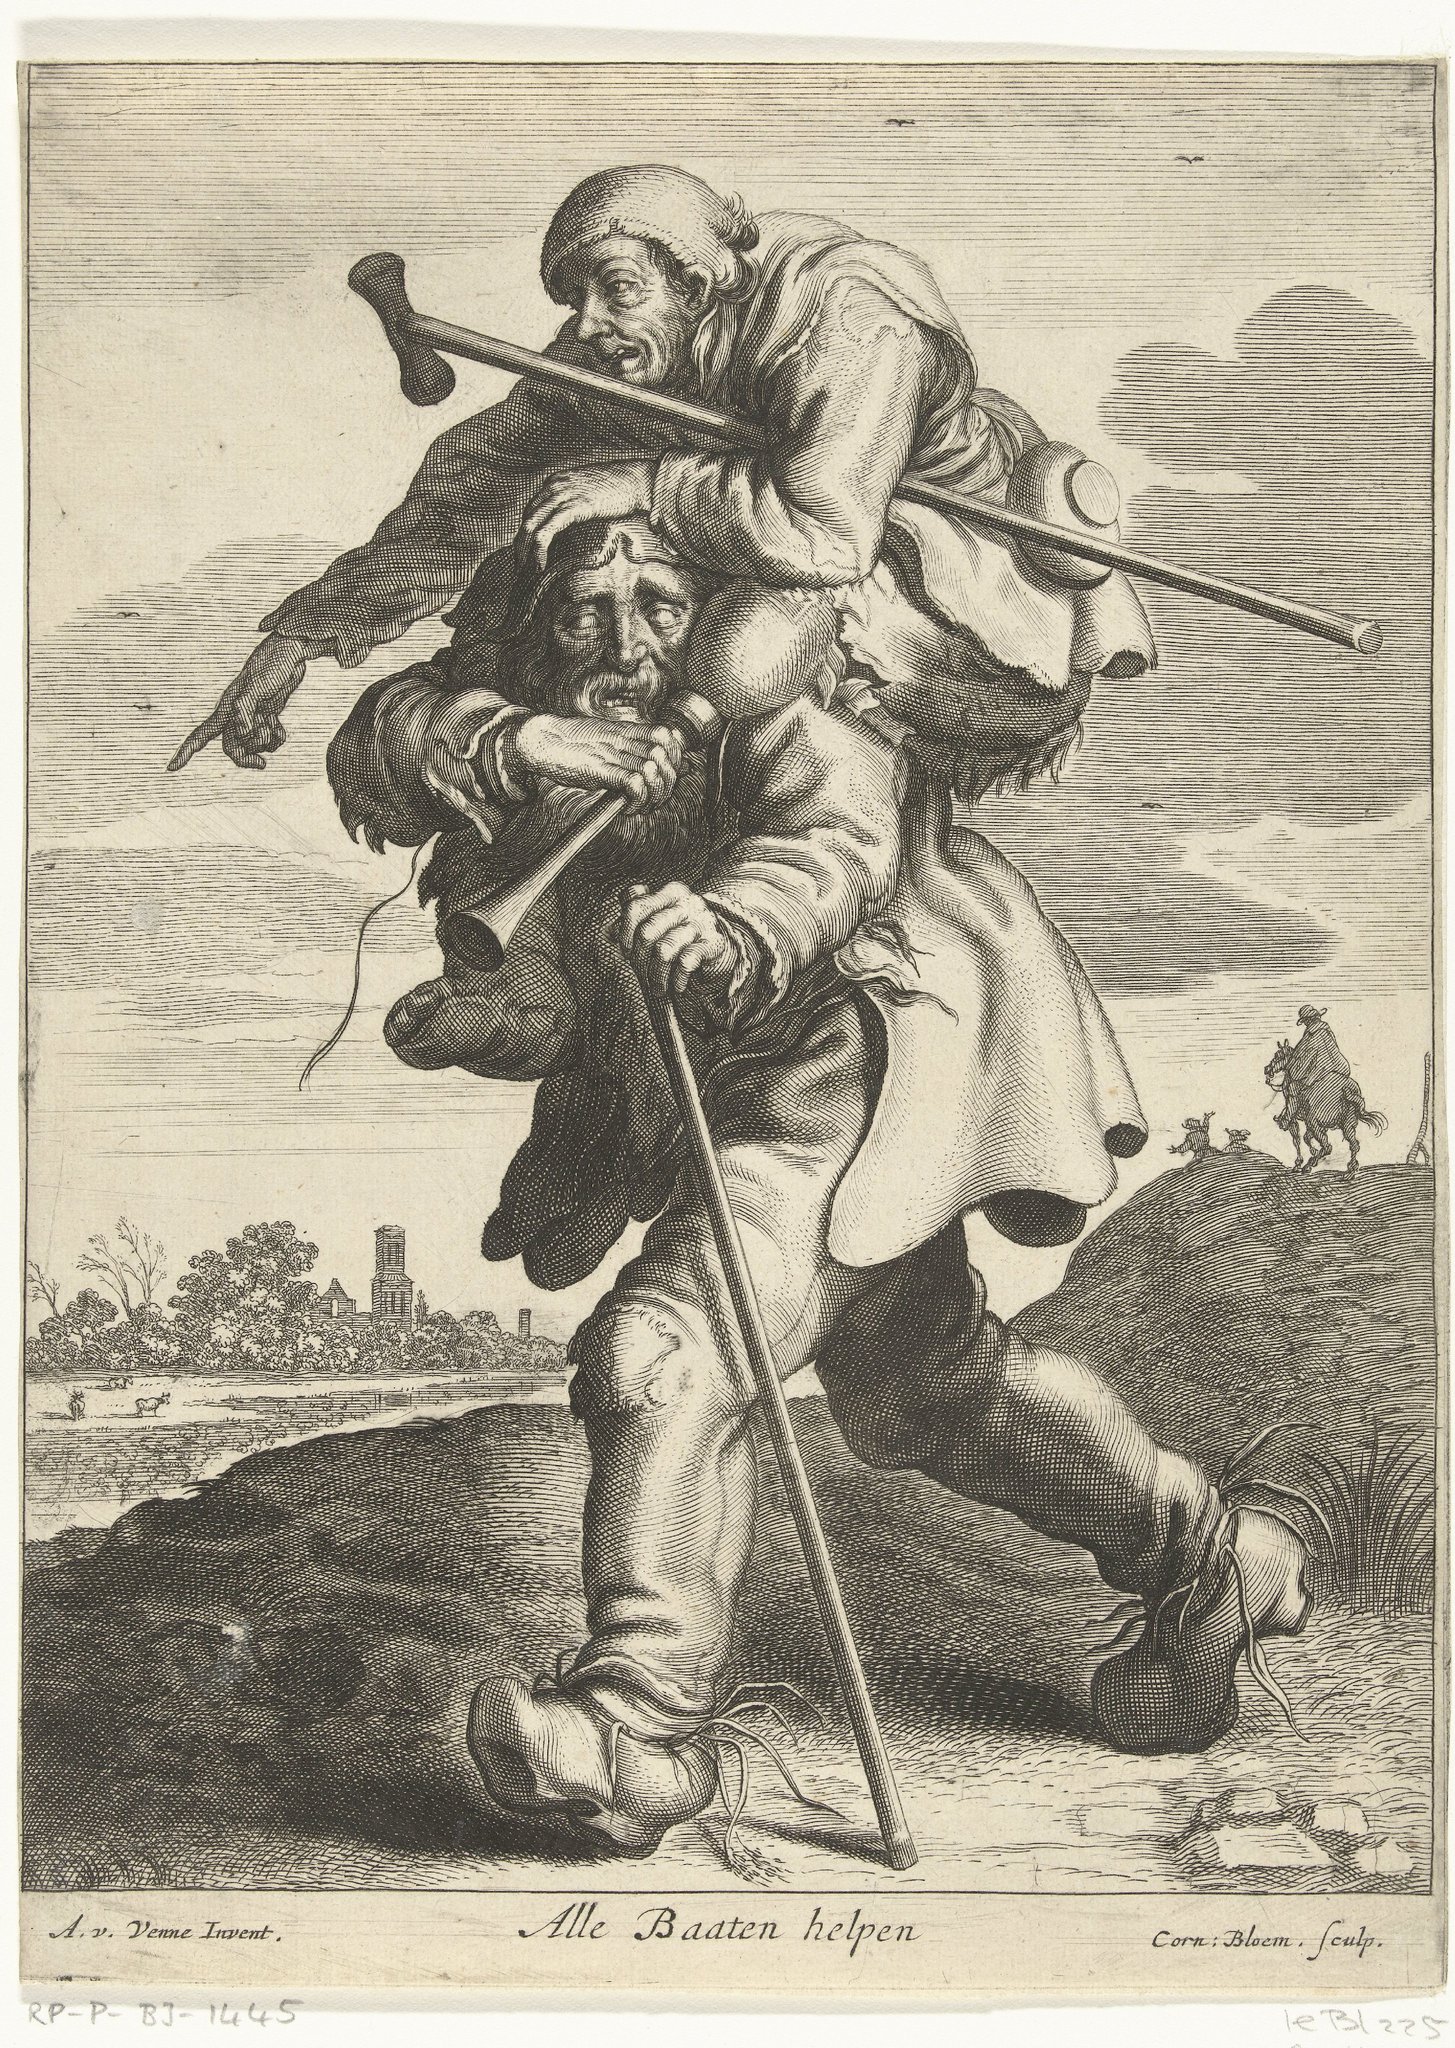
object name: print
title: De lamme en de blinde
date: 1620-1630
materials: paper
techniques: engraving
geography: utrecht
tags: proverbs, sayings, etc., the halt leading the blind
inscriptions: collector's mark: Lugt 240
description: Een blinde man draagt op zijn rug een verlamde man. De verlamde man wijst de blinde man de weg. Onderschrift: Alle Baaten helpen.